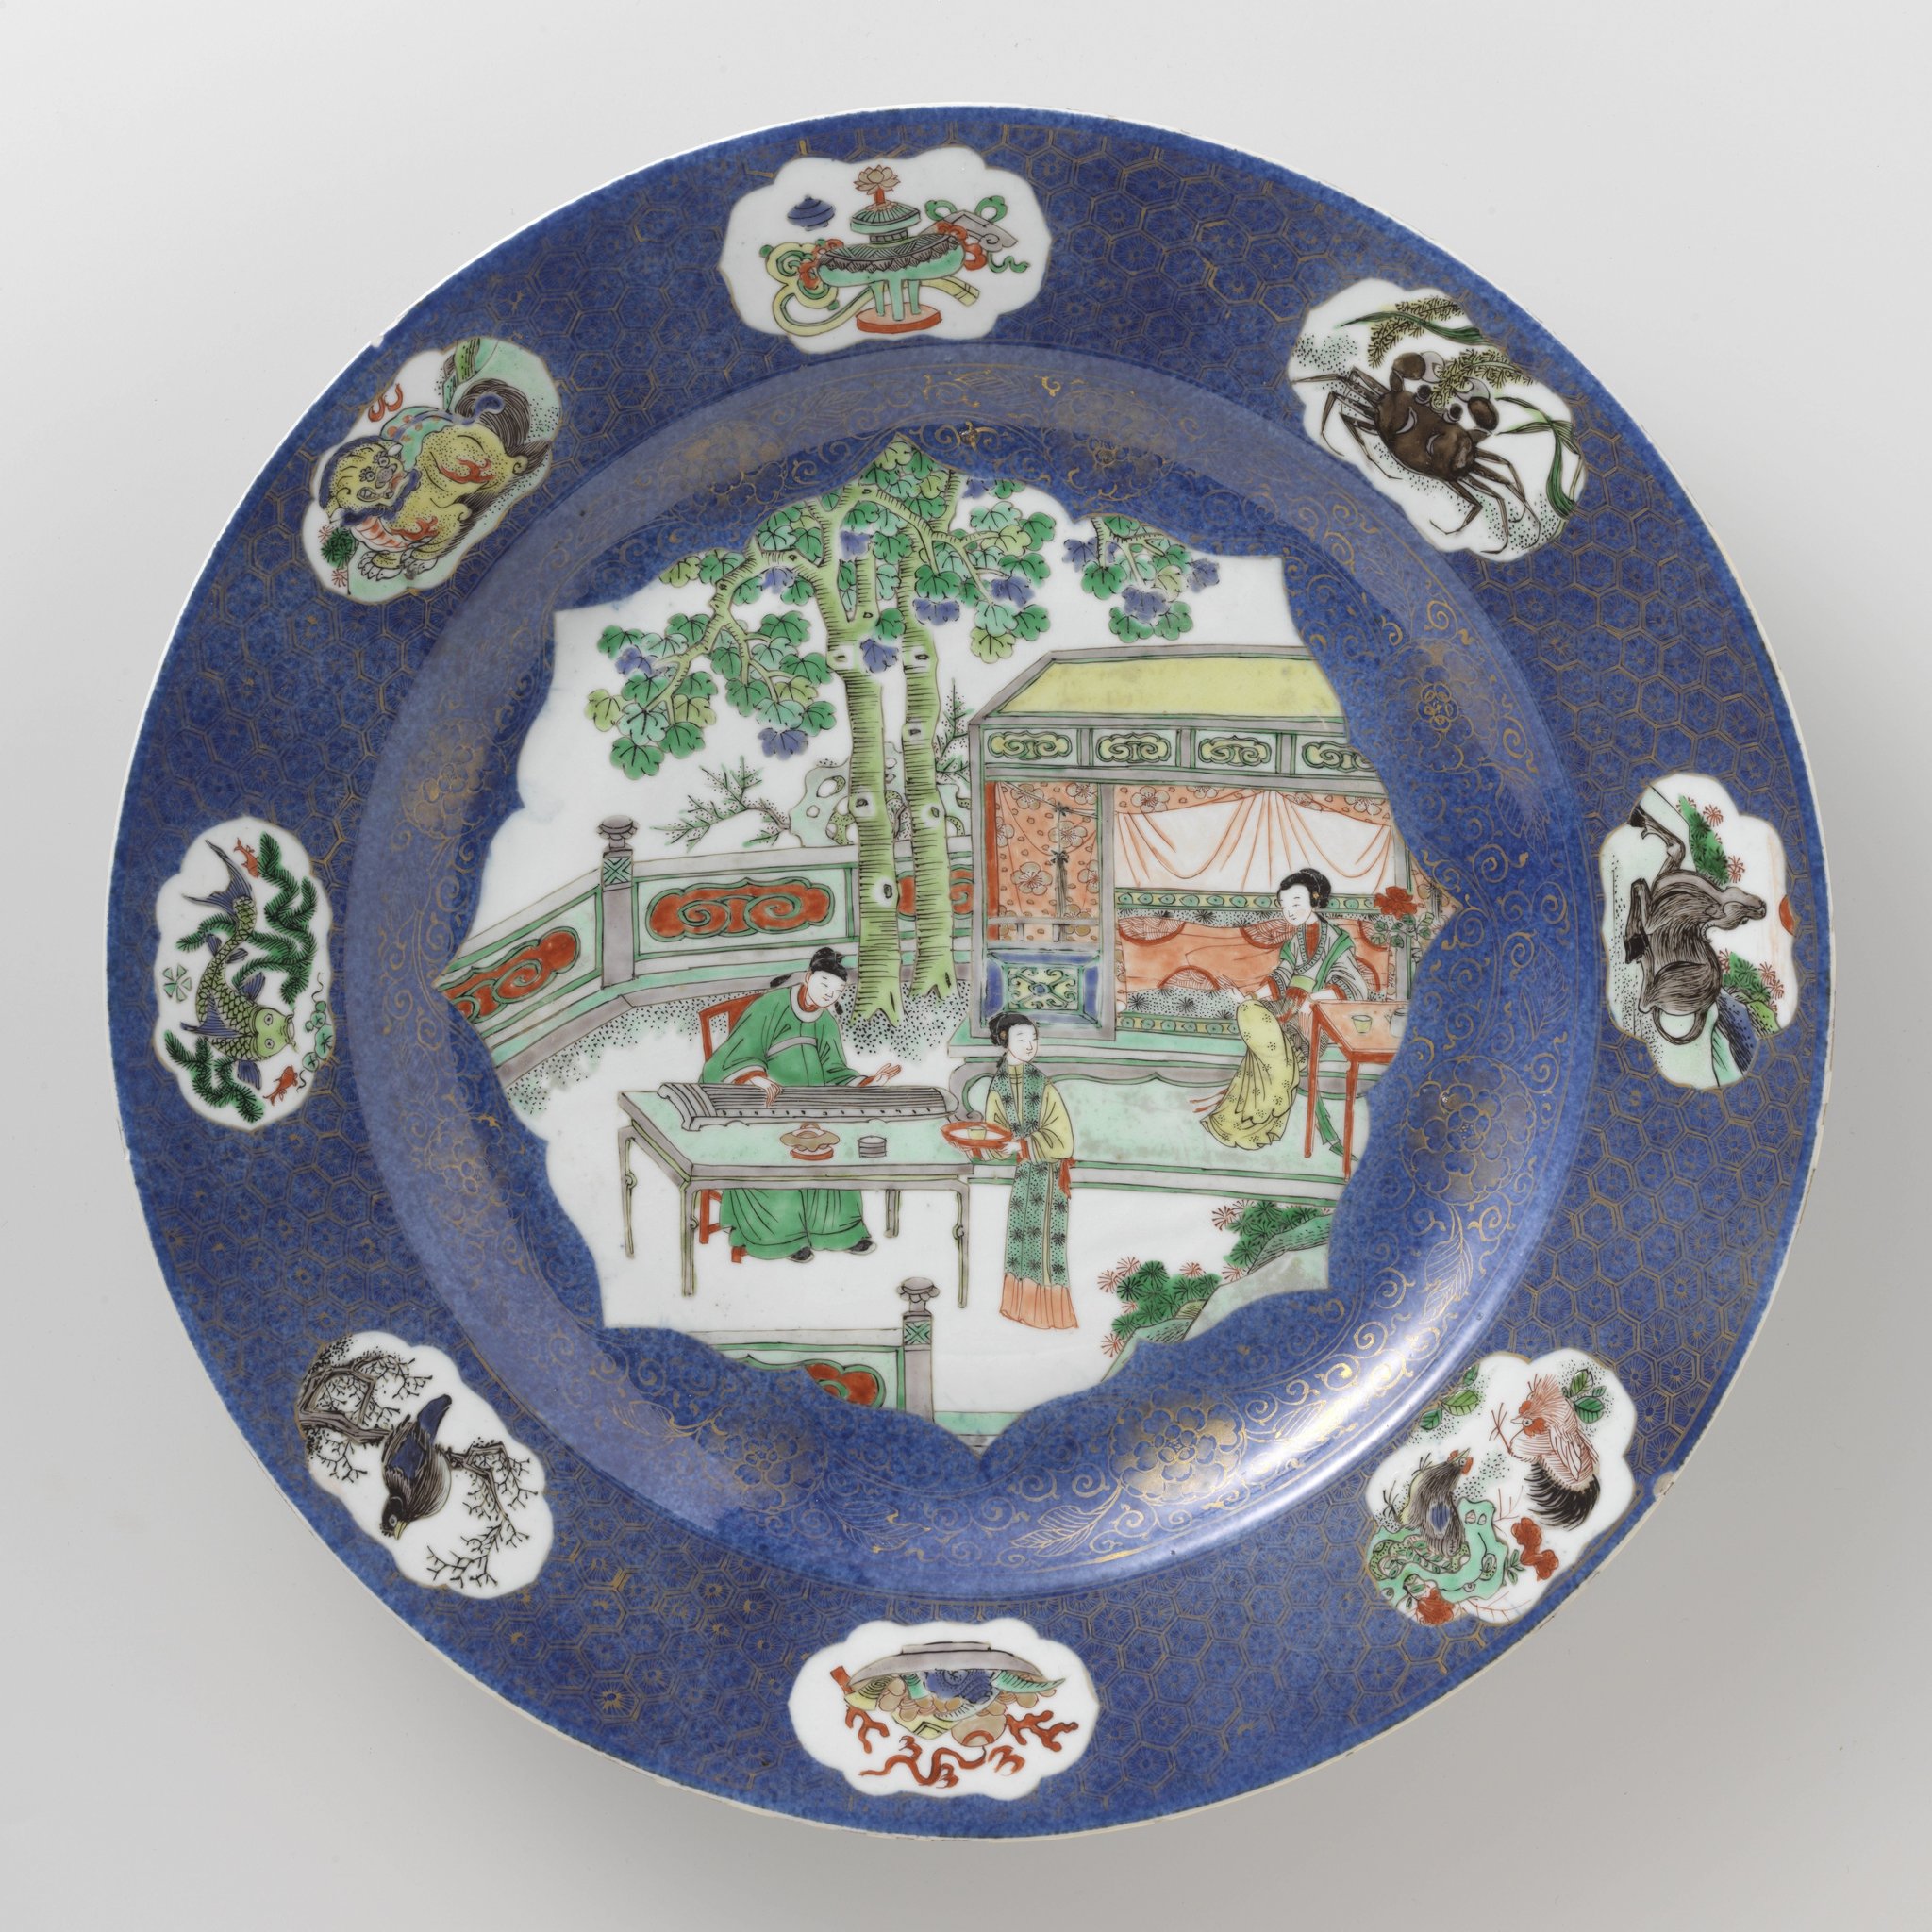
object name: platter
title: Dish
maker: Anonymous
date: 1700-1720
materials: cobalt, glaze, gold, paint, porcelain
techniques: firing, gilding, turning, vitrification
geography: china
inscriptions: mark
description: Until the late 17th century all porcelain ware had blue decorations, which were painted directly onto the unfired porcelain. This dish, however, also has other colours, applied with enamel: molten glass paste fused with the porcelain during firing. The blue of the dish’s border was applied in powder form, giving it a dappled, somewhat uneven appearance (an effect known as ‘powder blue’).